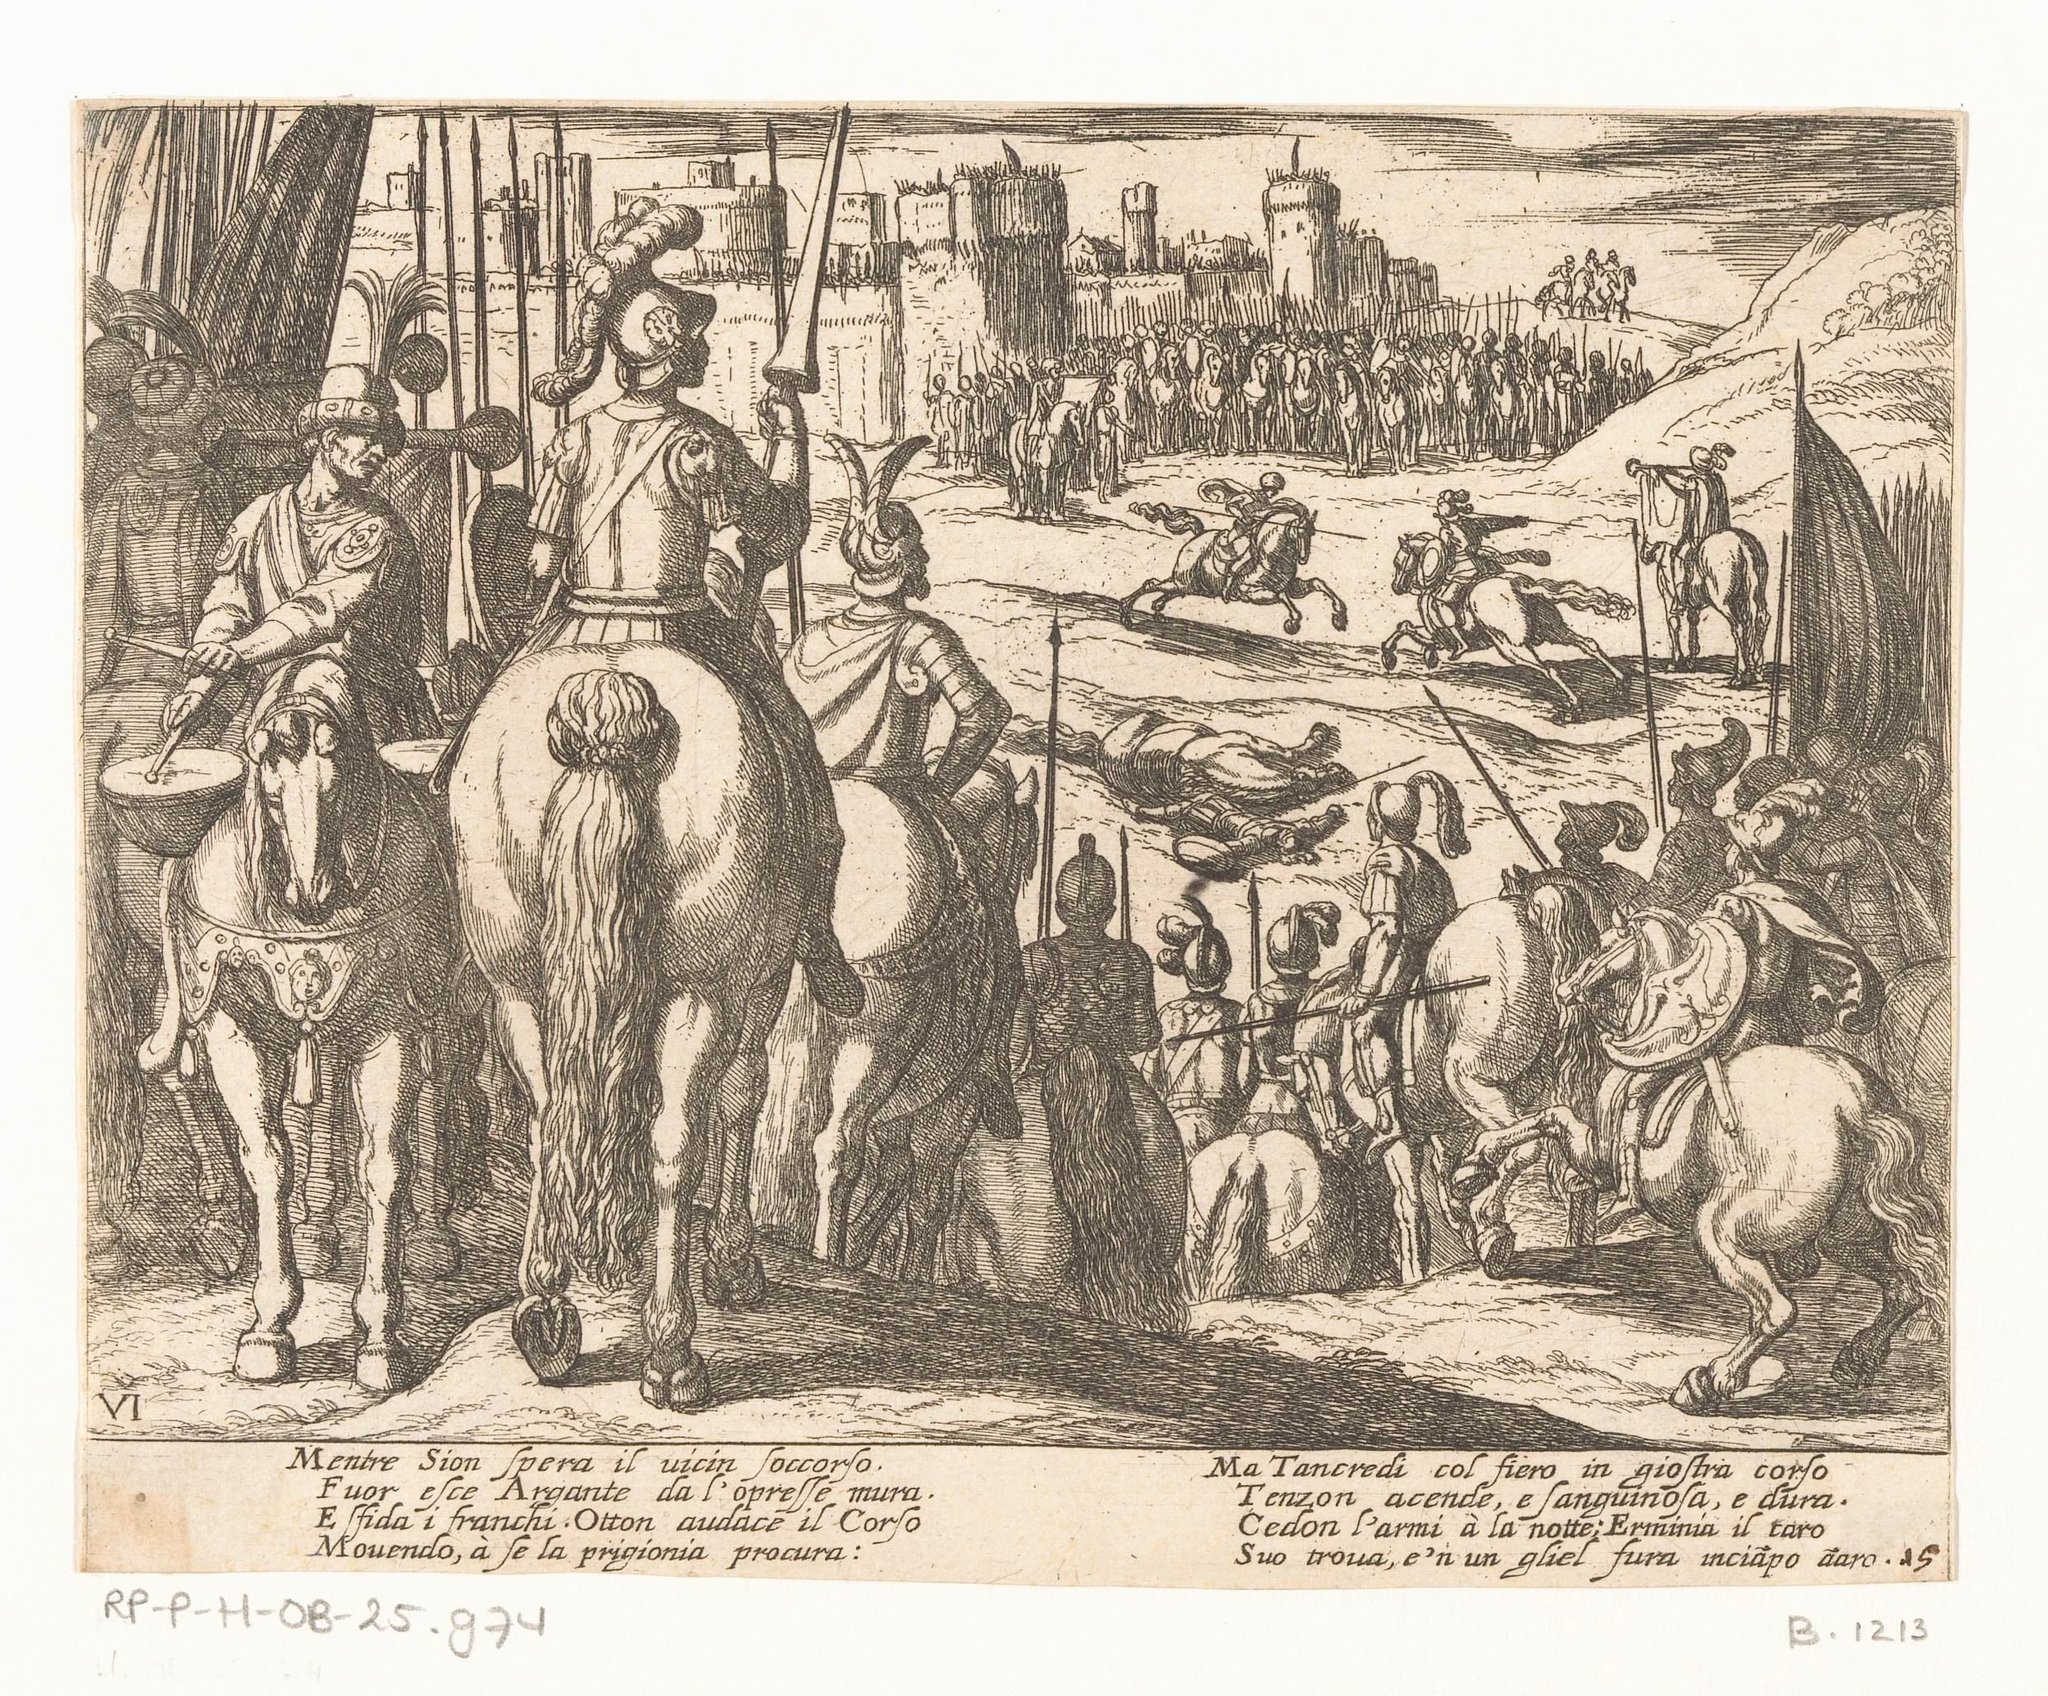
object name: print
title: Jeruzalem verlost (deel 2)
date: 1565-1630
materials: paper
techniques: etching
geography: italy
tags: battle, warfare; military affairs (+ cavalry, horsemen), militant proselytizing: religious war, crusade, etc., (scenes from) specific works of literature: tasso, gerusalemme liberata, knight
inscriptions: number: ‘15’, collector's mark: ‘Hinloopen’, collector's mark: Lugt 11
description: Deze prent maakt deel uit van een reeks van twintig prenten (+ opdracht) met voorstellingen van scènes uit Tasso's 'Jeruzalem verlost', een episch gedicht geschreven door de Italiaanse dichter Torquato Tasso en voor het eerst gepubliceerd in 1581. Het verhaal vertelt grotendeels in fictie over de Eerste Kruistocht waarin de christenen, geleid door Godfried van Bouillon, de strijd aangaan met de moslims om het Beleg van Jeruzalem.